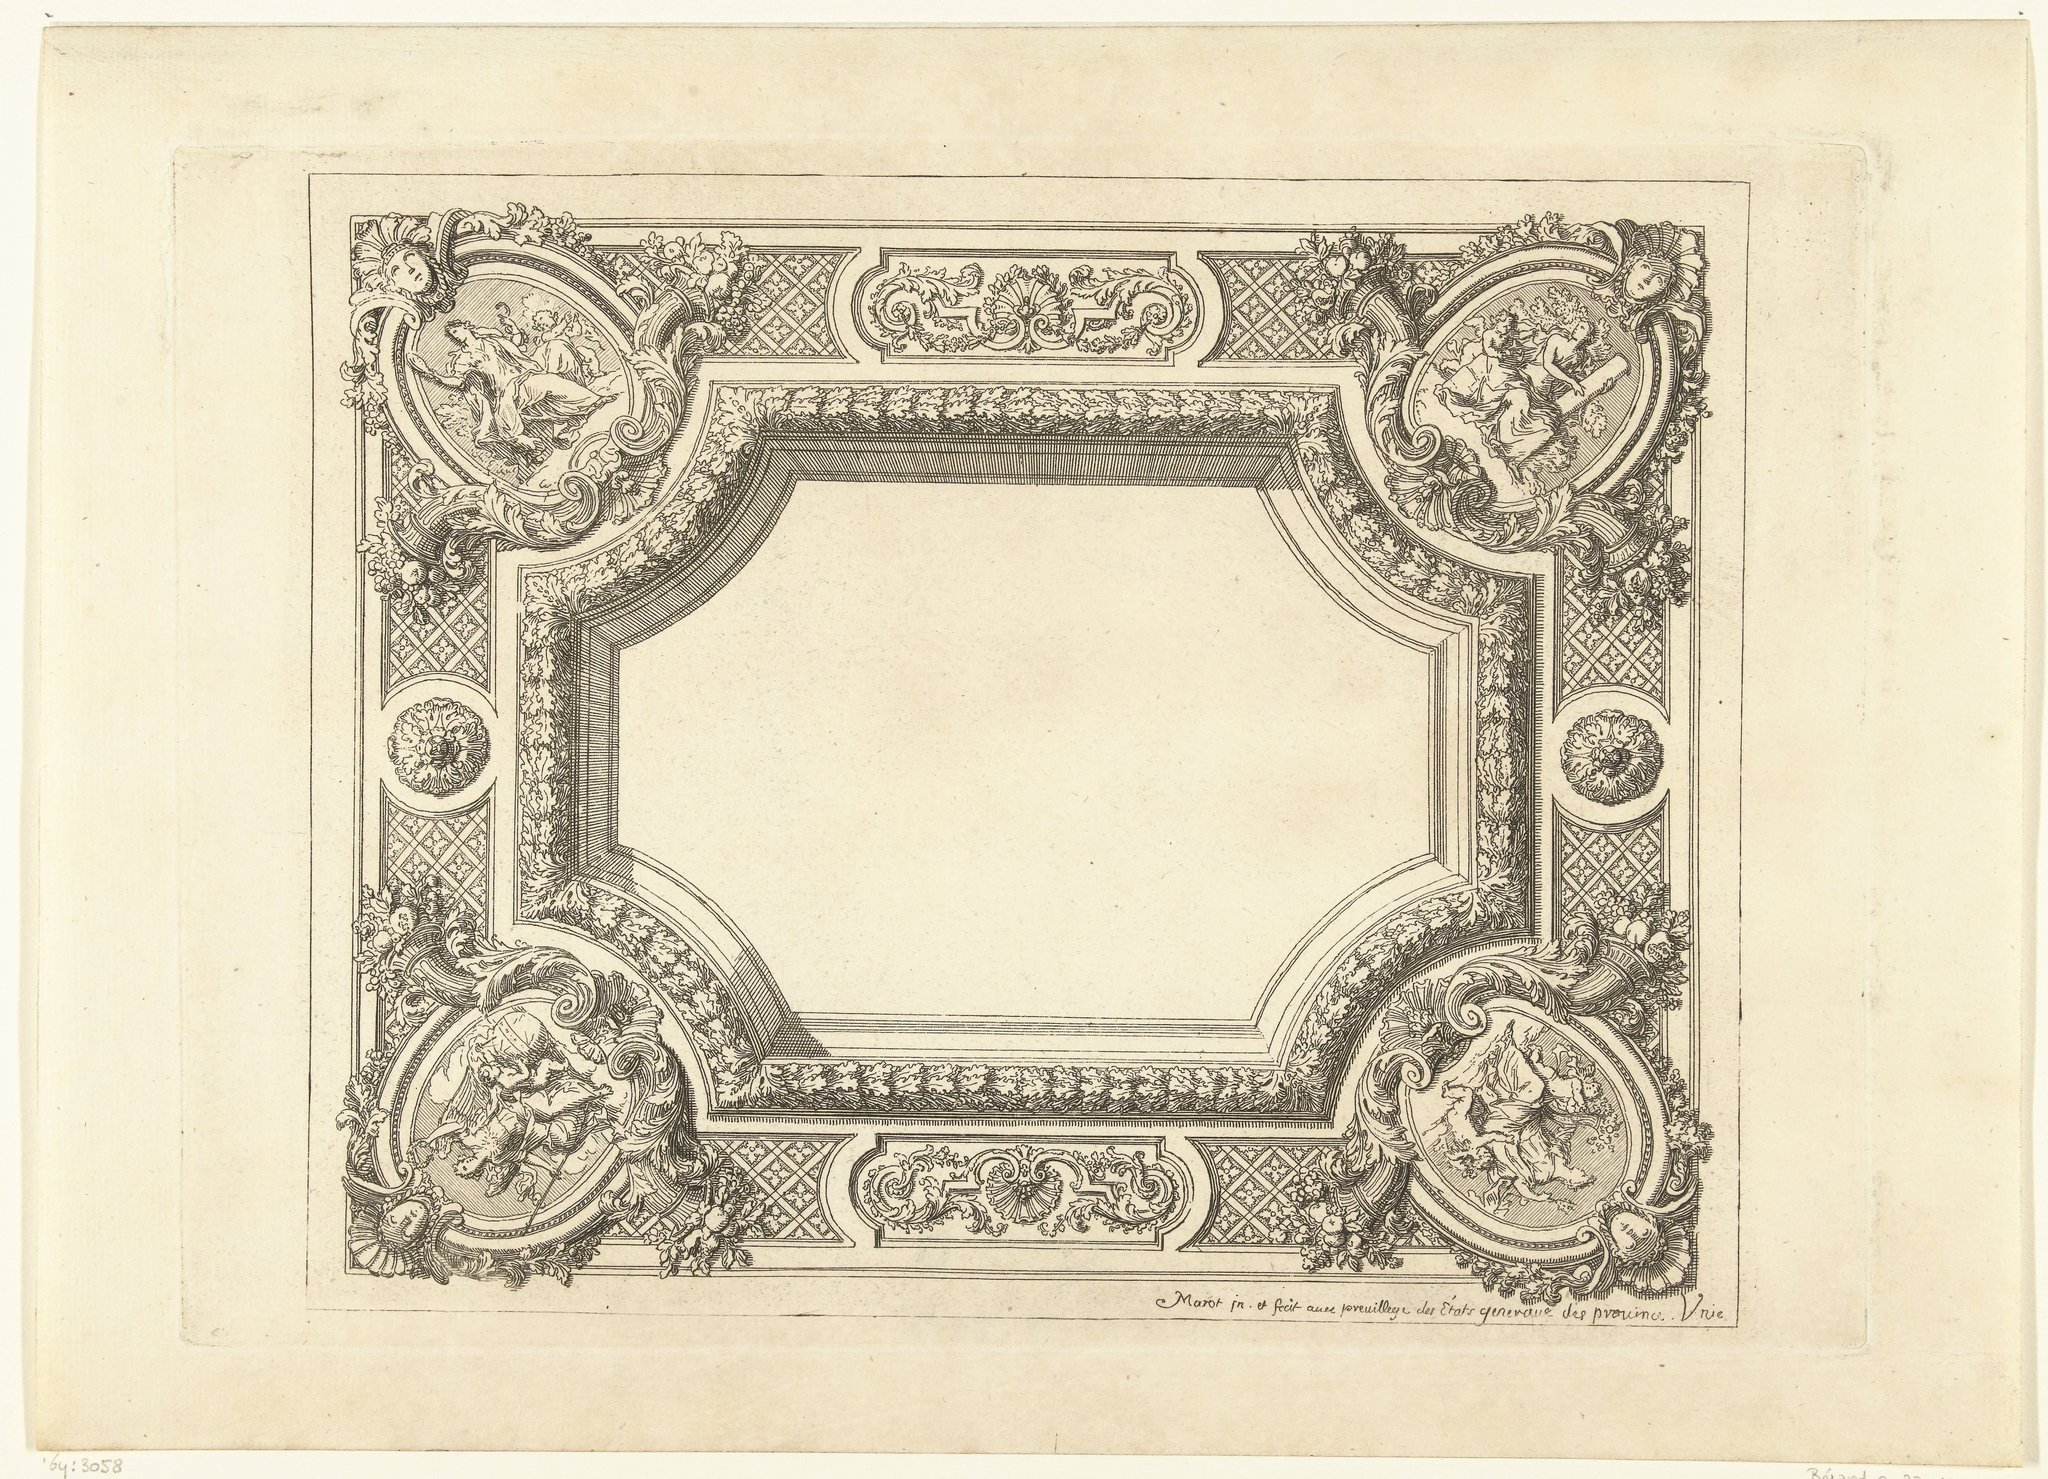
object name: ornament print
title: Plafonds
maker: daniël marot (i)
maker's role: draughtsman, print maker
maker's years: 1661-1752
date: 1712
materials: paper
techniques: etching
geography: netherlands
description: Plafond met leeg middenstuk met gebogen hoeken. Het middenstuk is omringd door een ornamentele rand en medaillons met allegorische figuren in de hoeken. Uit serie van 6 (mogelijk 12) bladen.